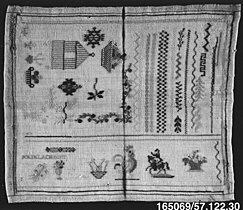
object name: sampler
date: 1801-1900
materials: cotton, silk, wool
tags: human figures,horses,leaves